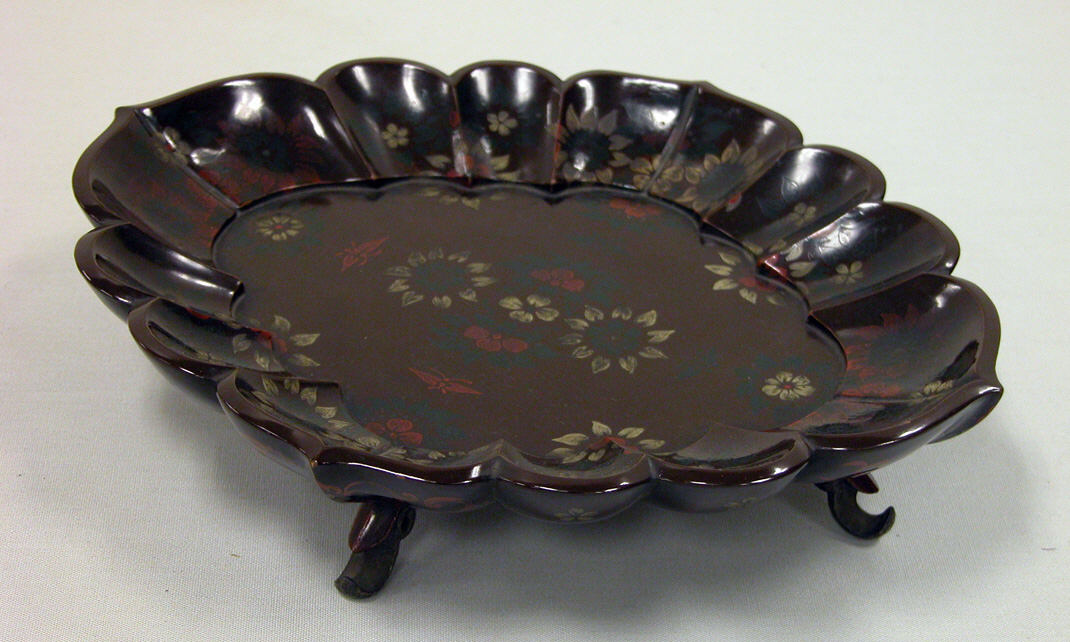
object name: cake tray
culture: japanese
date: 1701-1800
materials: lacquer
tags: flowers